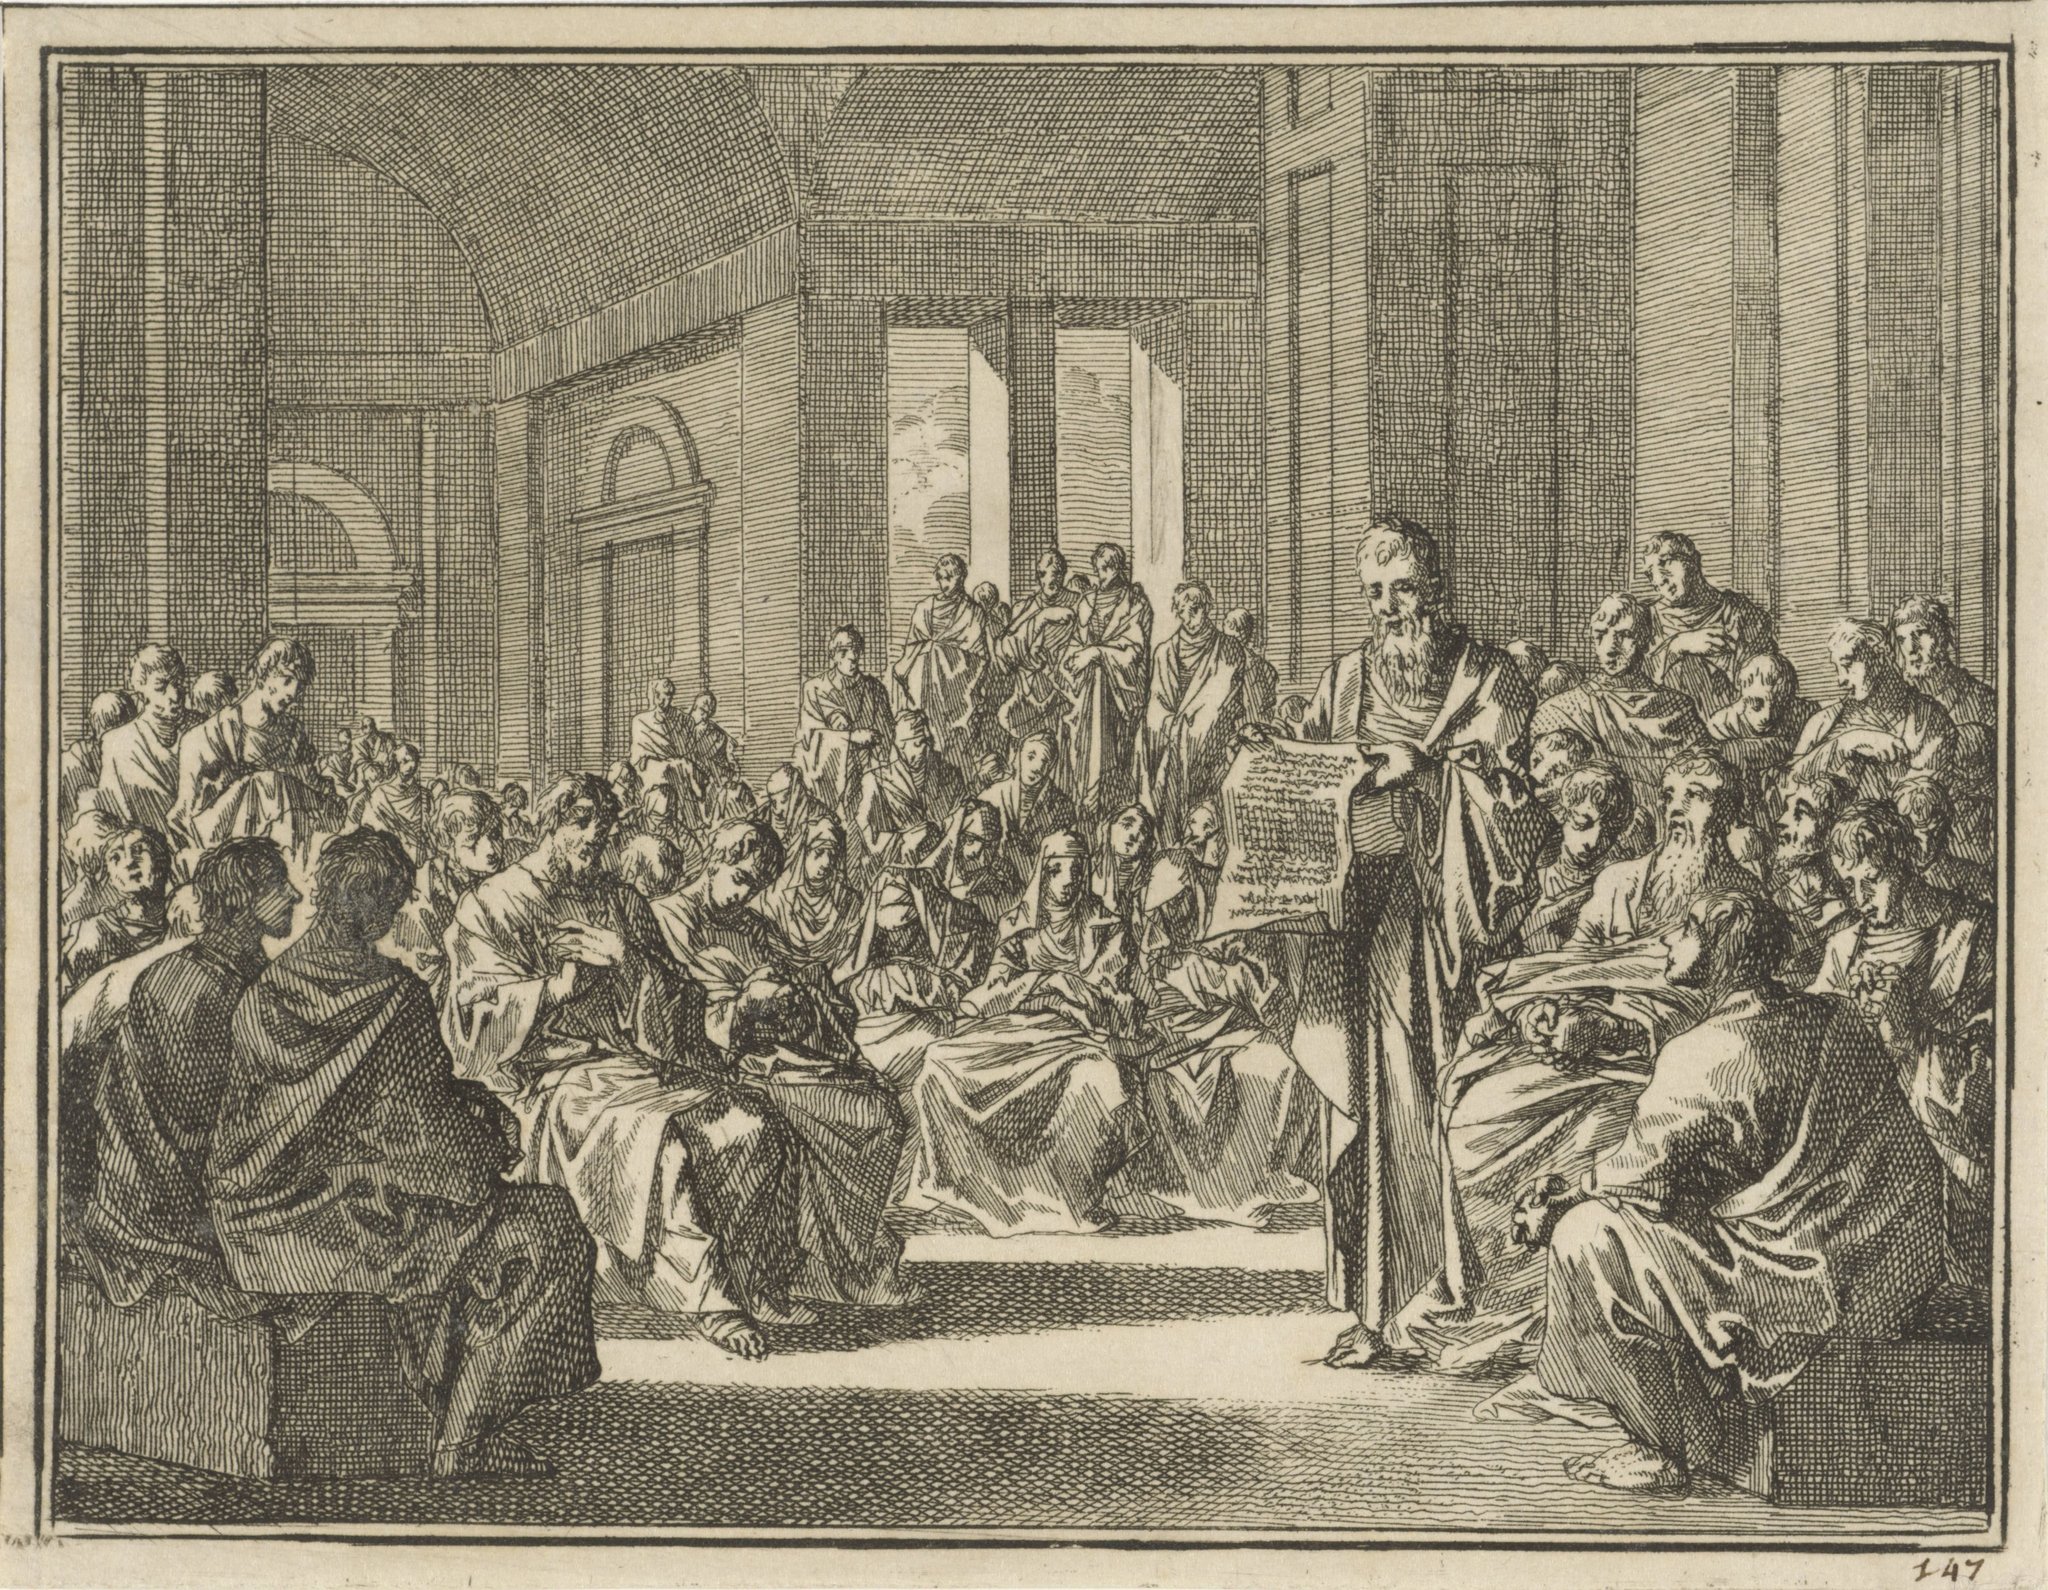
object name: print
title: Voorlezing van een zendbrief voor een grote menigte Christenen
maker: jan luyken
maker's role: draughtsman, print maker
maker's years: 1649-1712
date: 1712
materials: paper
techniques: etching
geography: amsterdam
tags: epistles of paul to communities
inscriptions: number: ‘147’, collector's mark: Lugt 2228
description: Proefdruk van illustratie uit: Luyken, Jan. De schriftuurlyke geschiedenissen en gelykenissen van het Oude en Nieuwe Verbond, 2 delen. Amsterdam: Wed. Pieter Arentsz II en Cornelis van der Sys, 1712, dl. II.